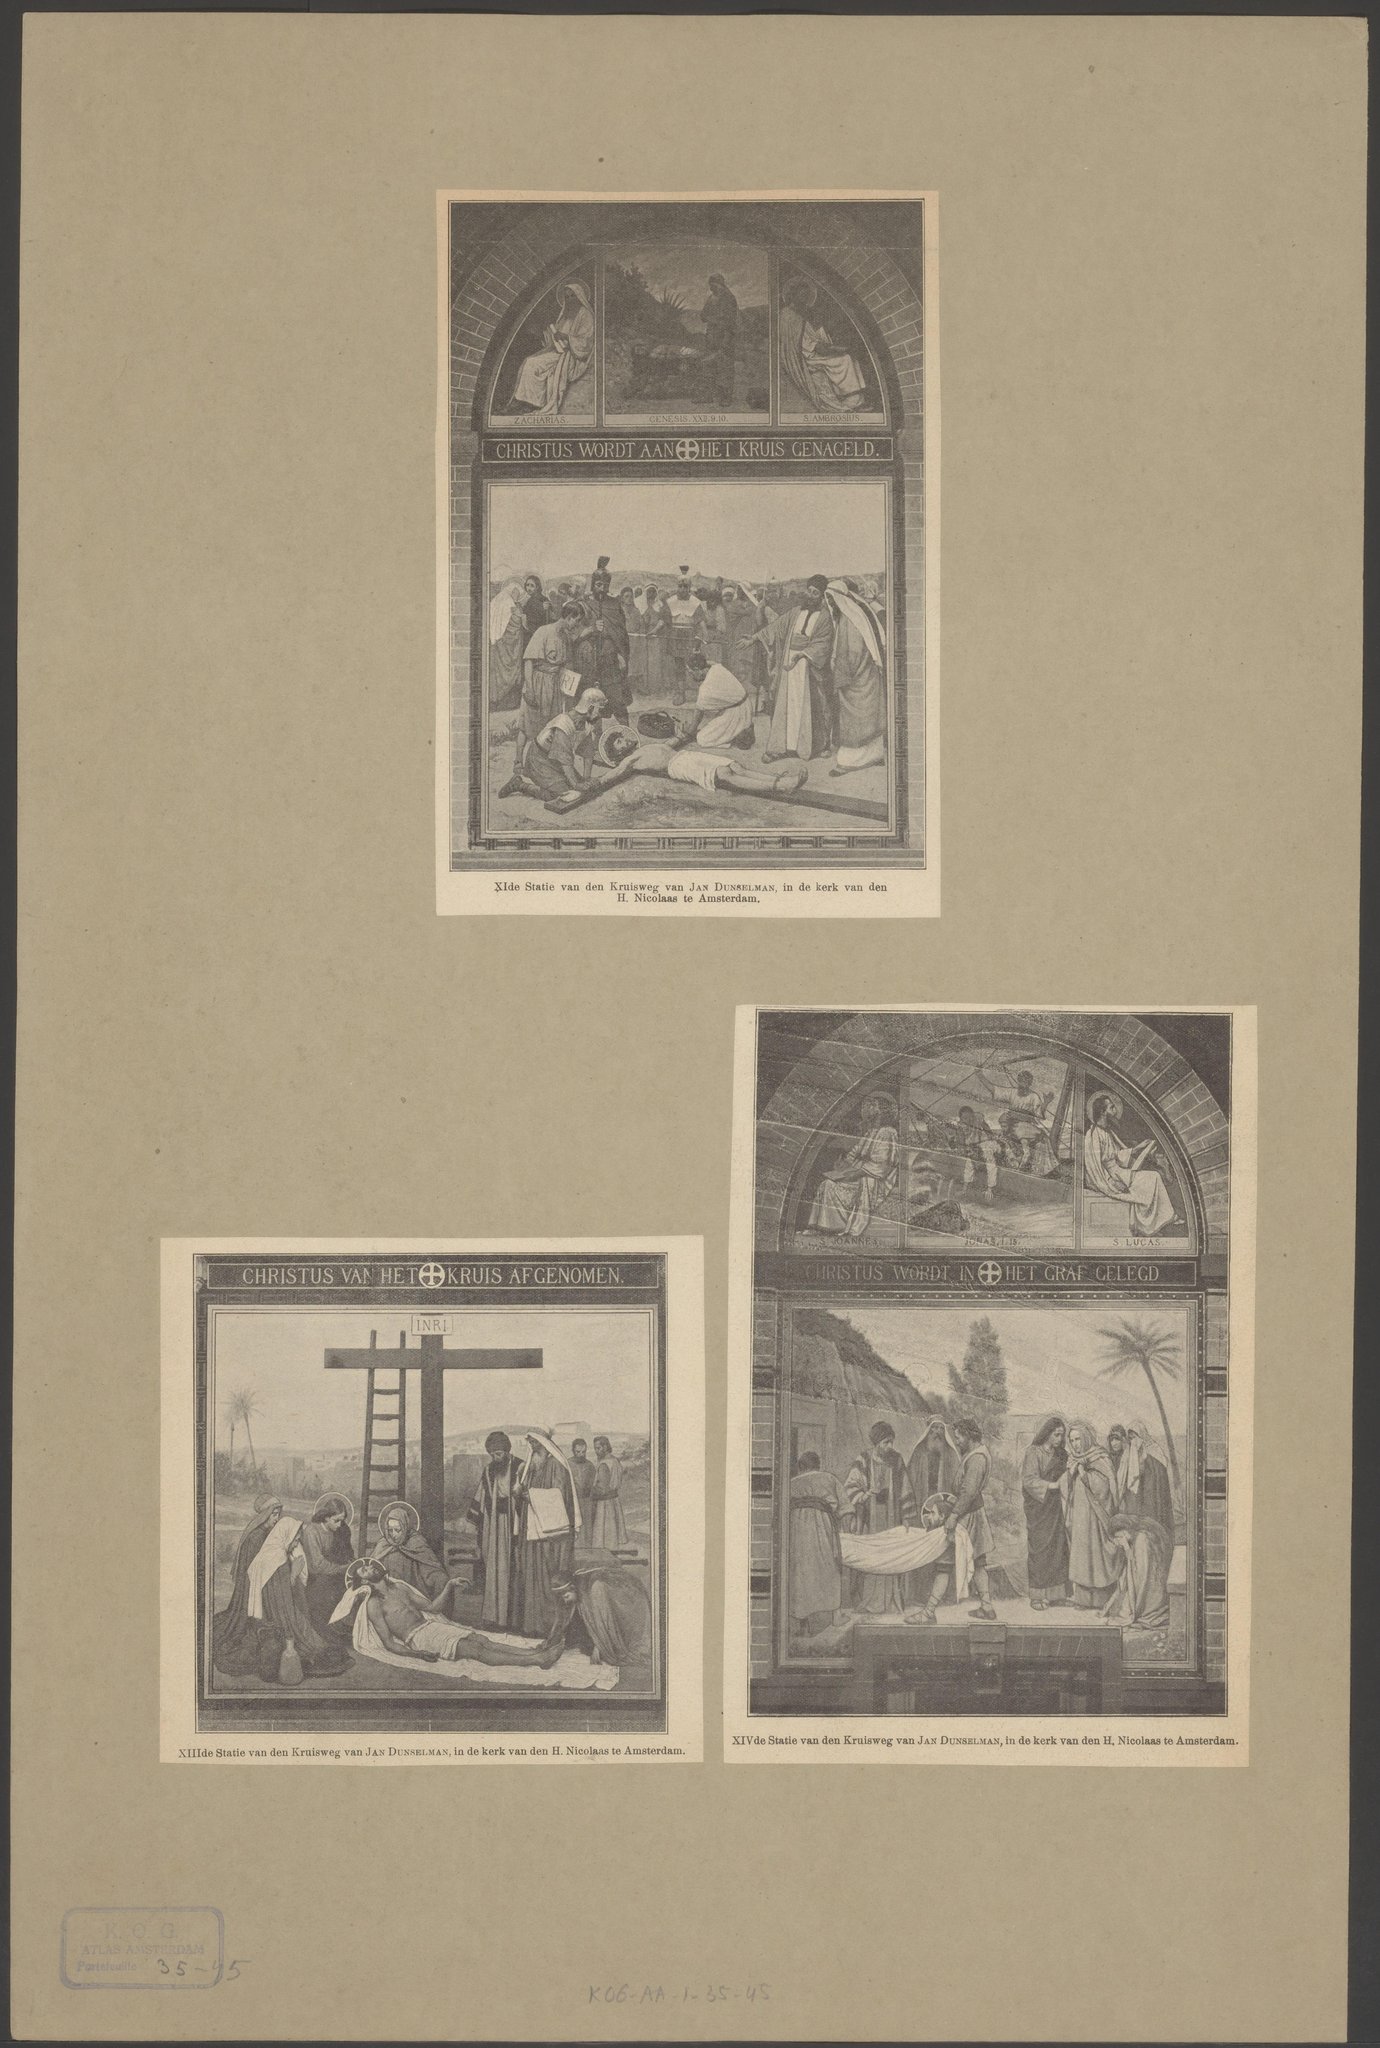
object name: photomechanical print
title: XIIIde Statie van den Kruisweg van Jan Dunselman, in de kerk van den H. Nicolaas te Amsterdam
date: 1928-1940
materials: paper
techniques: letterpress printing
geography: amsterdam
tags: the erection of the cross: christ is nailed to the cross which lies on the ground, christ is laid down ~ descent from the cross, interior of church, bearing of christ's body to the grave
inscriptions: collector's mark: ‘35-45’ Lugt 1641b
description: De Kruisiging, de Kruisafname en de Graflegging van Christus. Geknipt uit een onbekende publicatie. Onderwerpsrubriek binnen de Atlas Amsterdam: R.K. Gemeenten: Sint Nicolaaskerk t/m Willibrordus (Rustenburgerstraat).